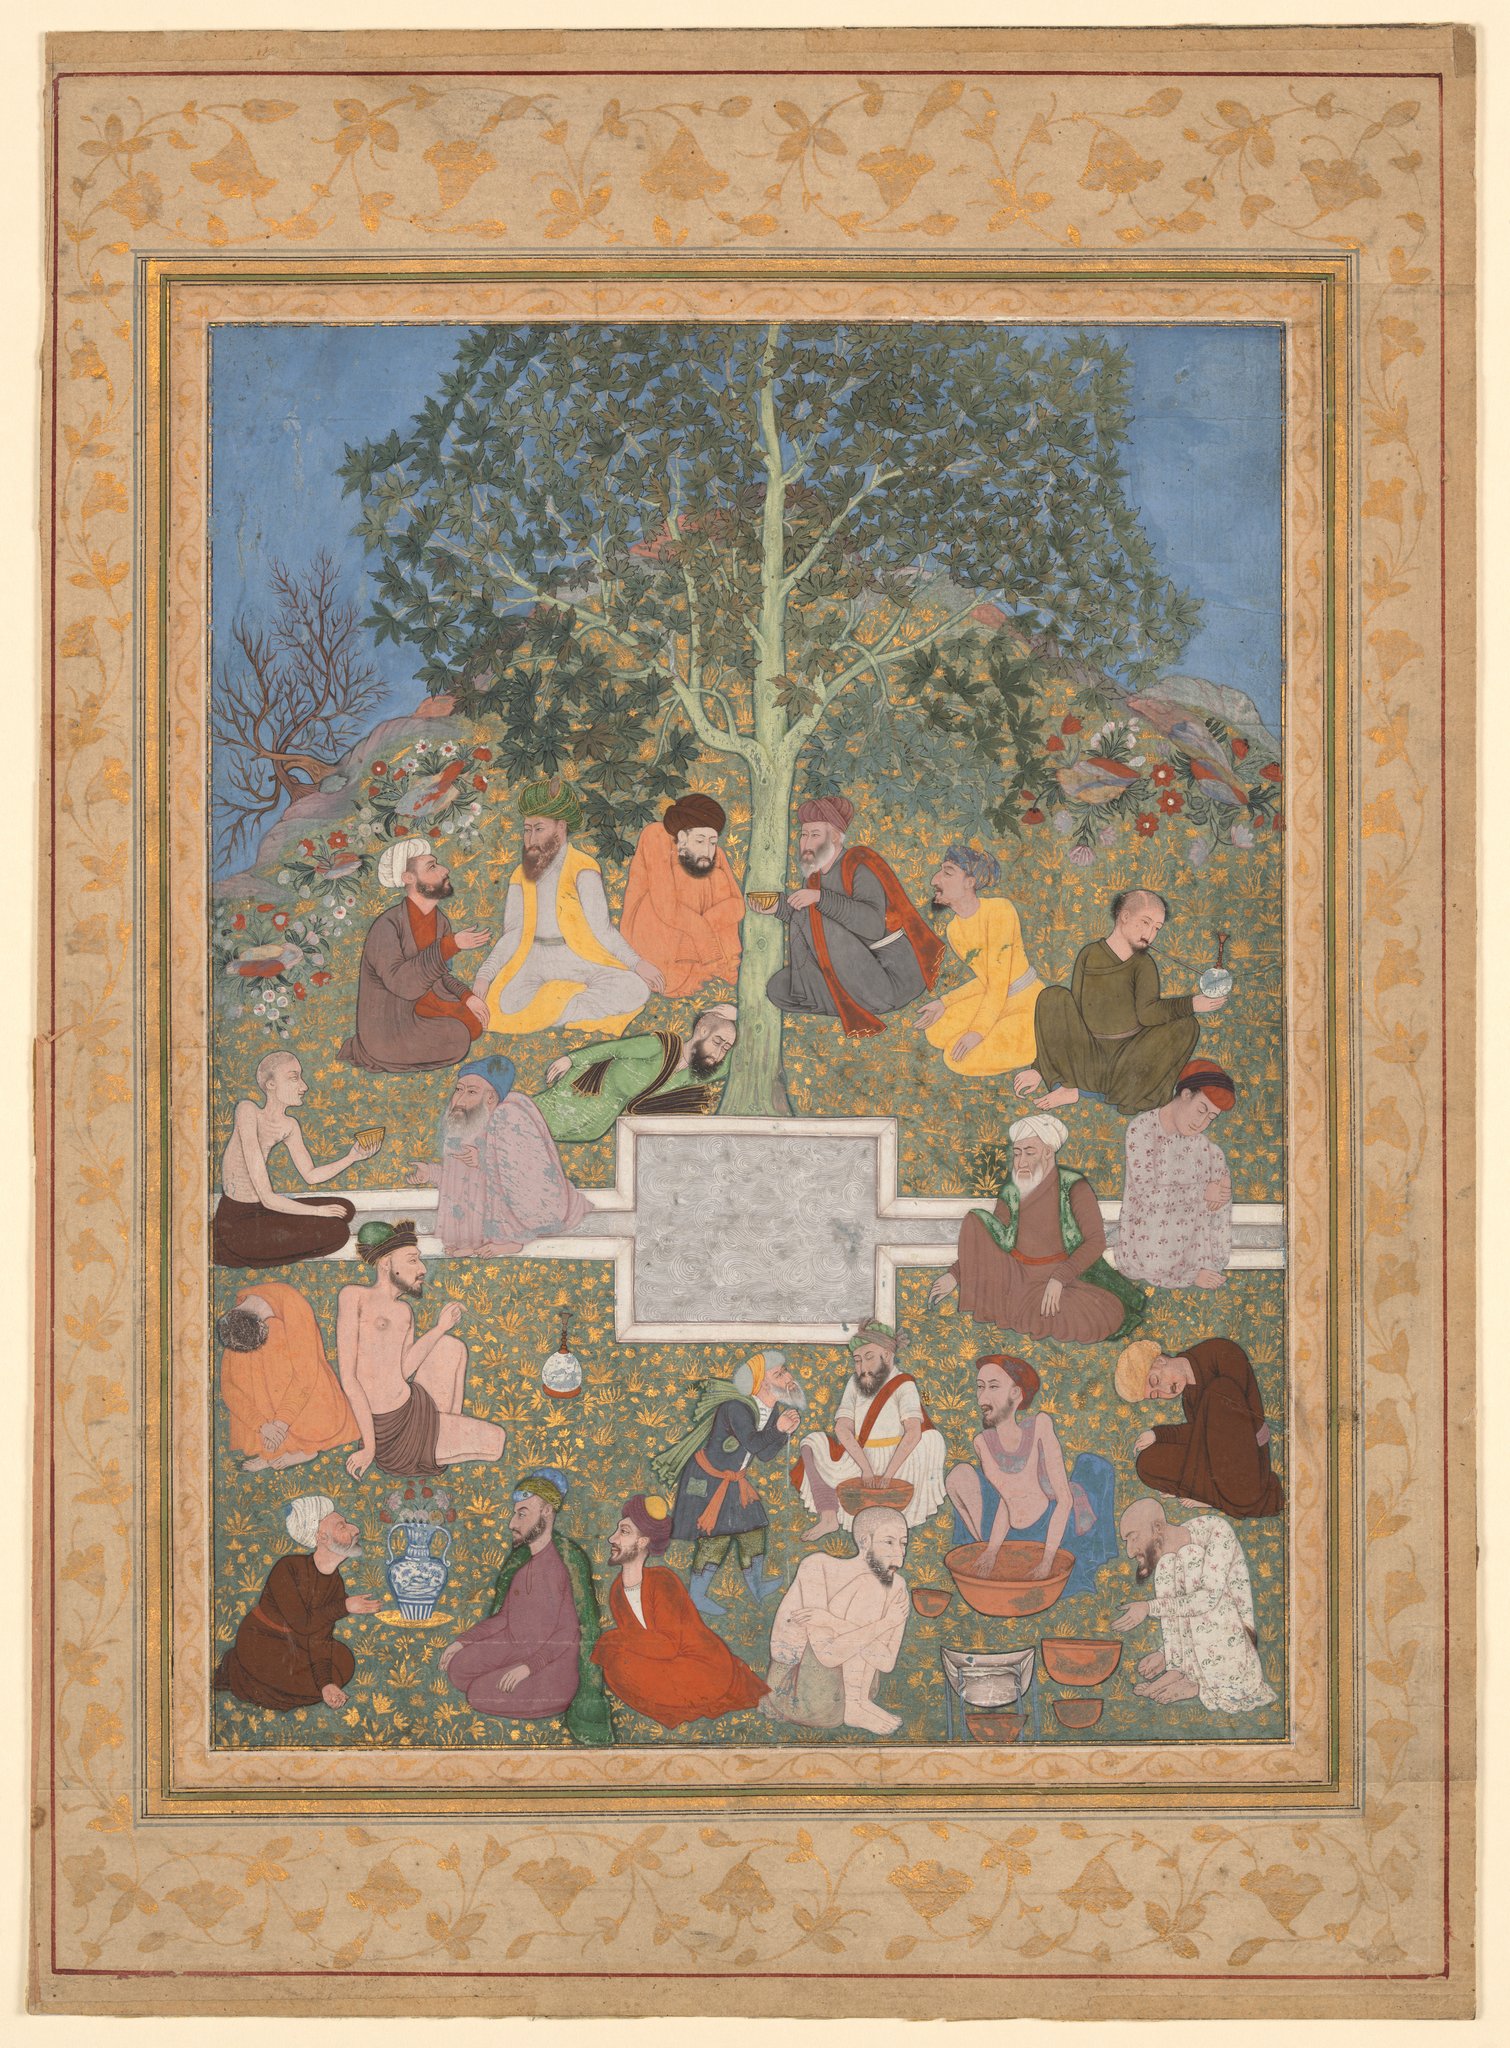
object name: illustrated single work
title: A Gathering of Dervishes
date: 1605-1610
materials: gold, paper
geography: india